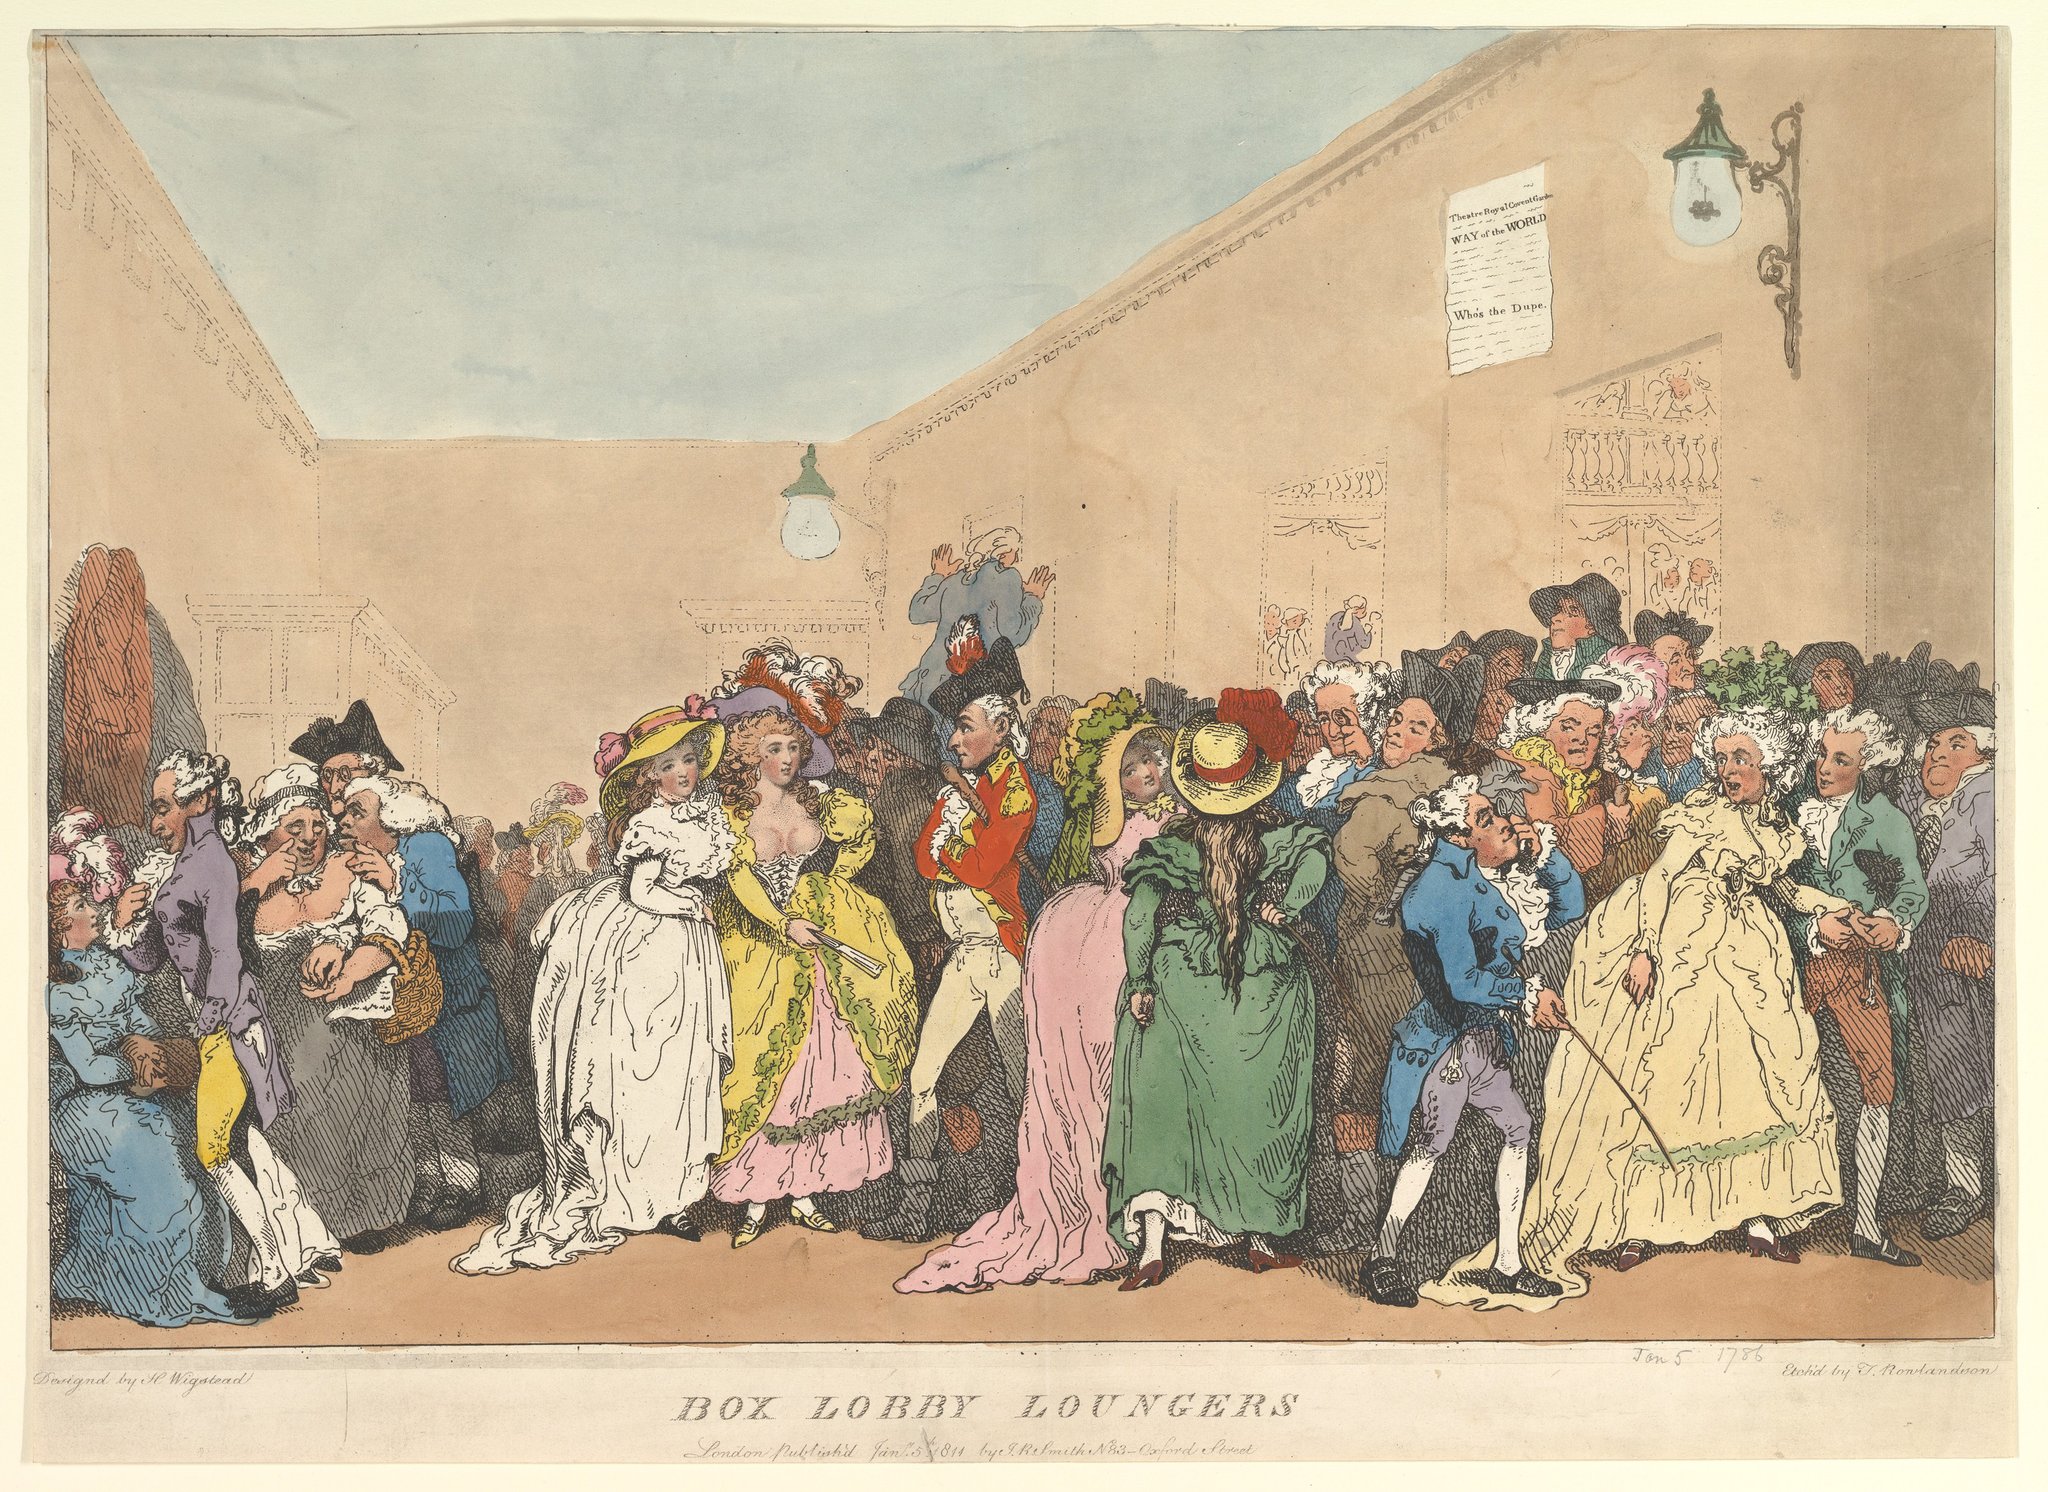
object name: print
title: Box Lobby Loungers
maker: thomas rowlandson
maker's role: artist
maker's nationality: british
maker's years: 1757-1827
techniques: etching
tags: satire,men,women,crowd